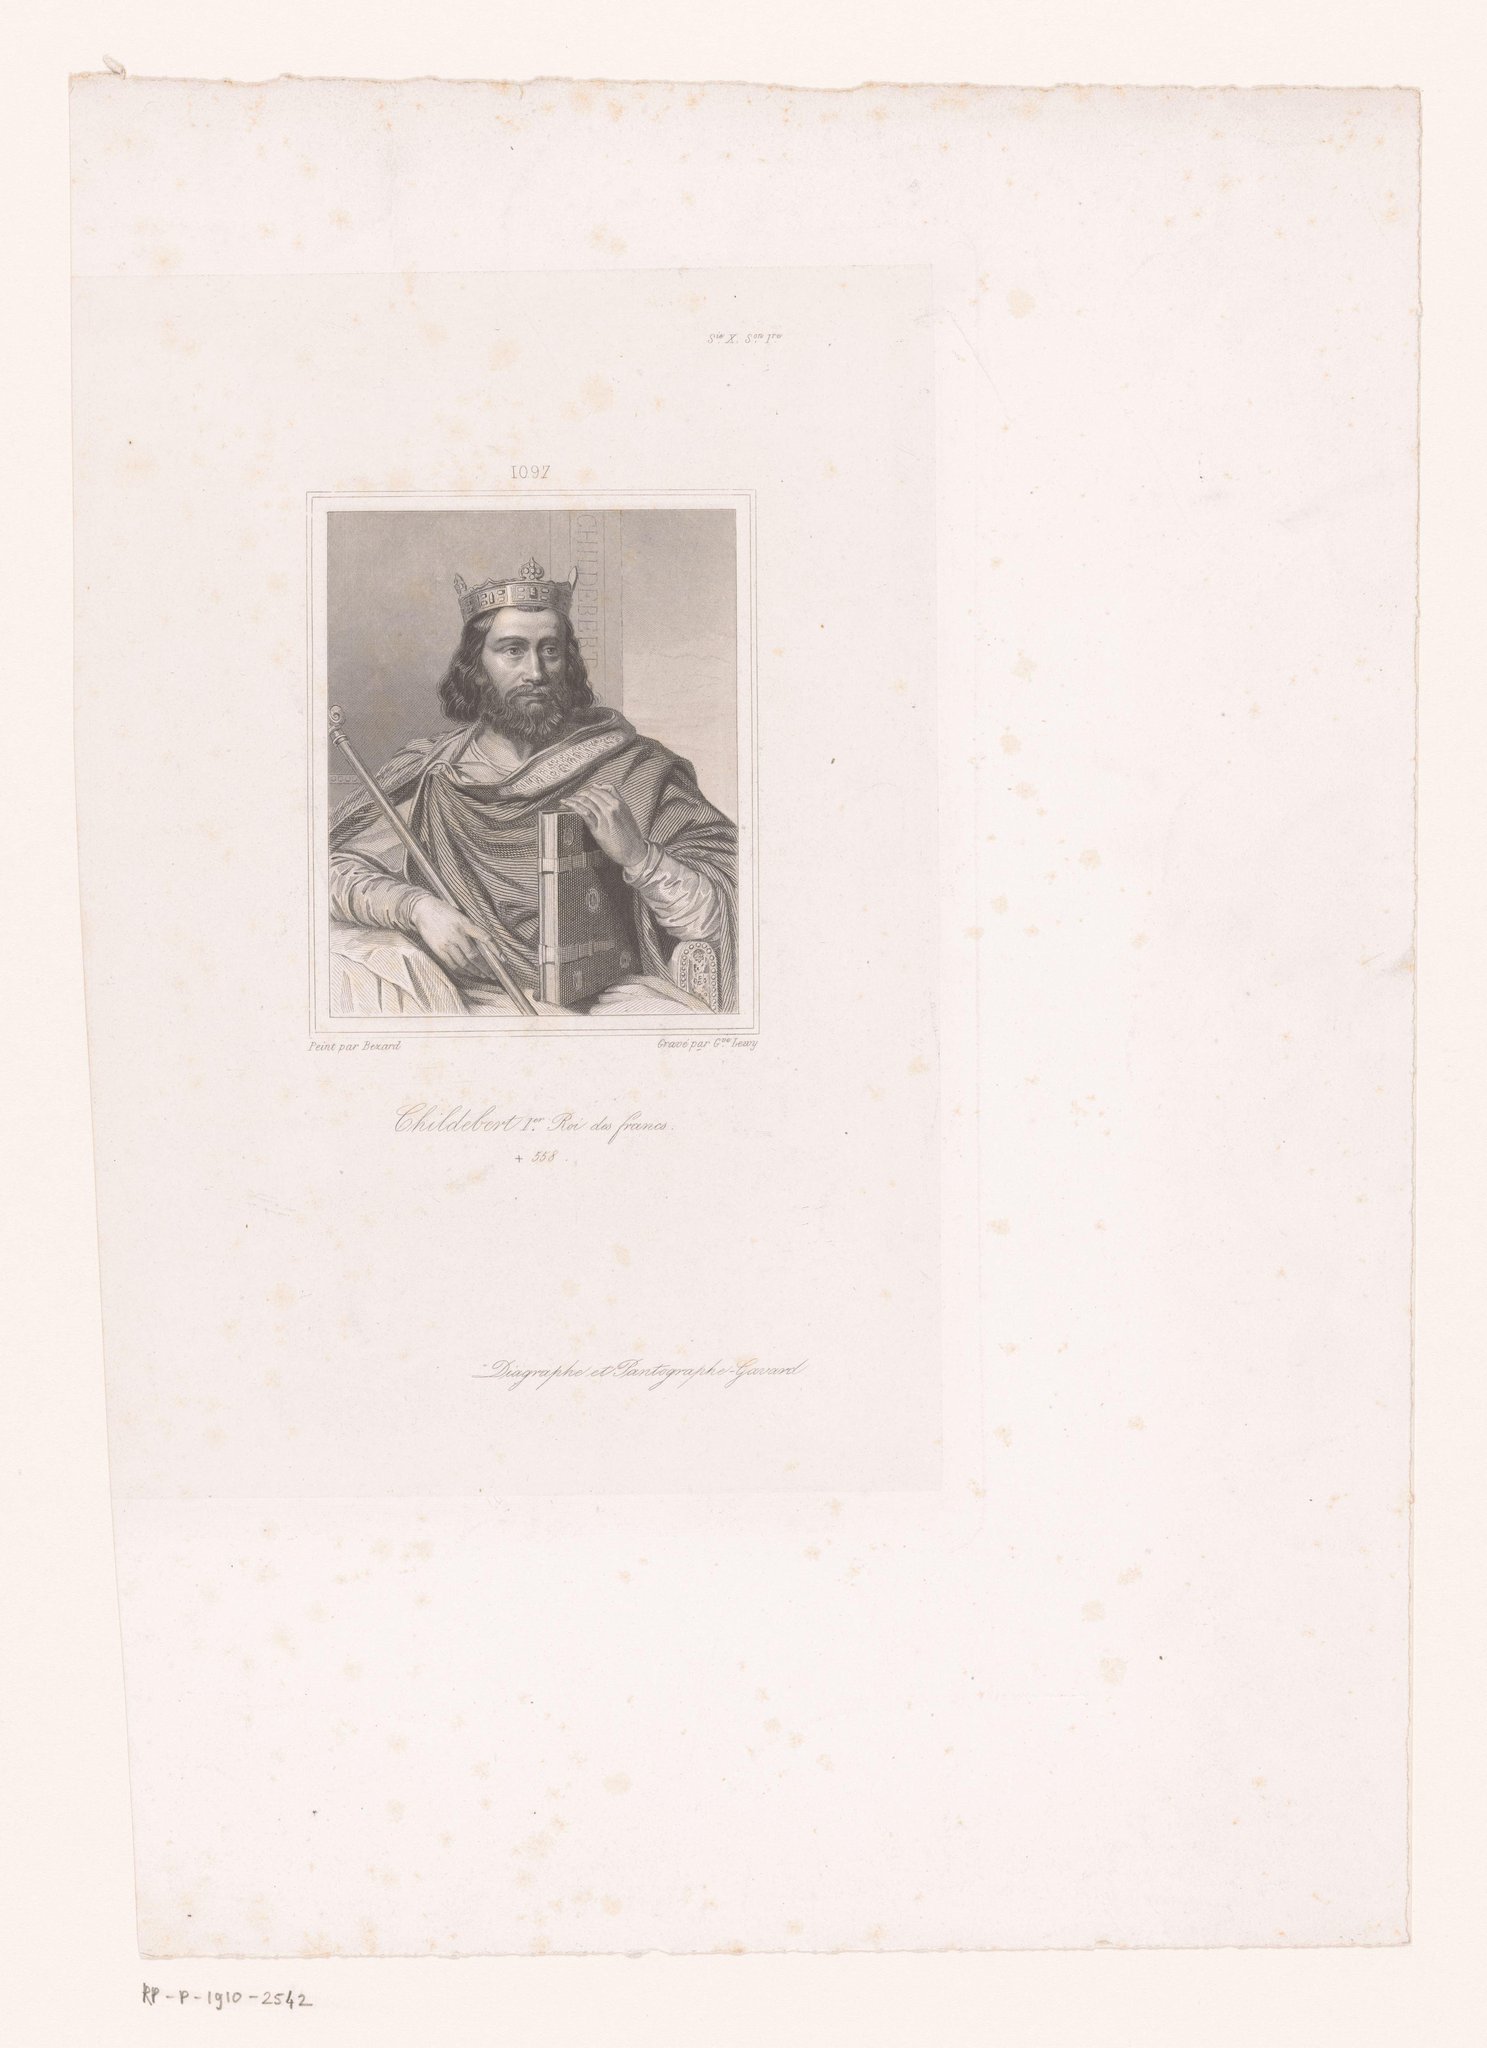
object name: book illustration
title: Childebert Ier Roi de francs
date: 1838-1841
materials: paper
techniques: engraving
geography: paris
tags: historical persons, king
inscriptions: collector's mark: Lugt 2228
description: Prent uit: Galeries historiques de Versailles. Parijs: Charles Gavard, 1838-1841.